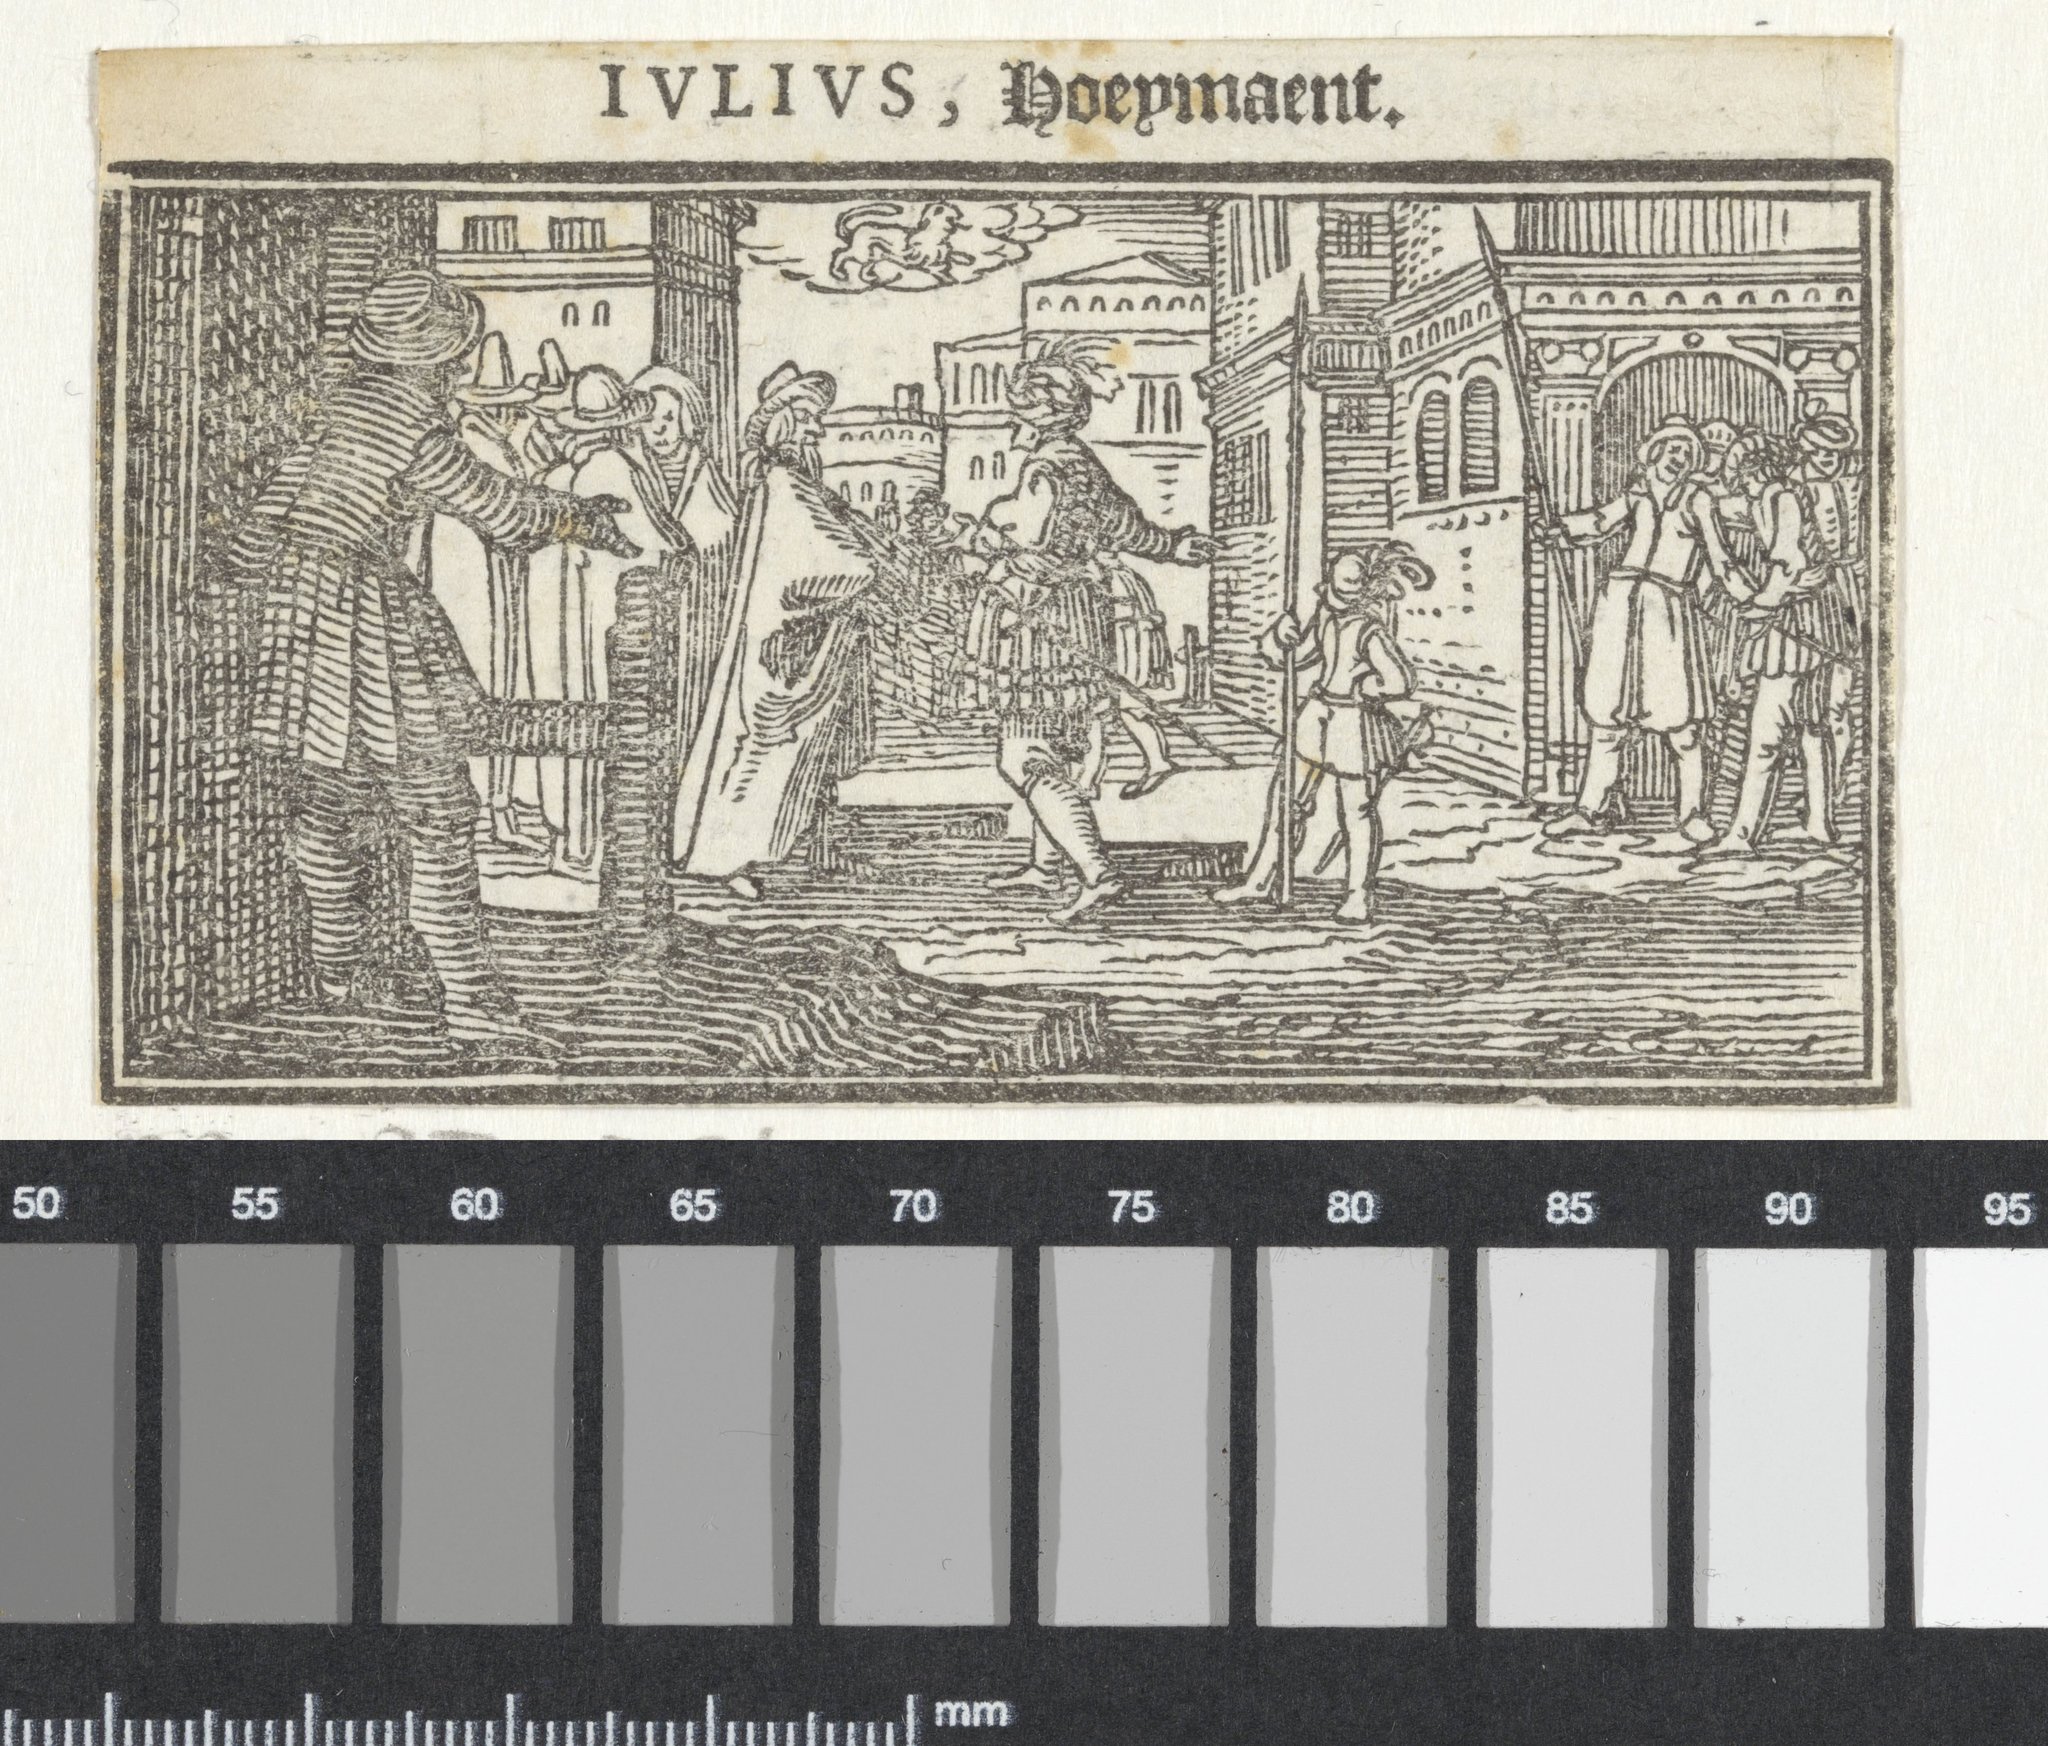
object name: book illustration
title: Maanden van het jaar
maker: Anonymous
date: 1600-1699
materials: paper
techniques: letterpress printing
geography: netherlands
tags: 23n31(+132)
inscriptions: collector's mark: Lugt 2228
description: Een rijk geklede man maakt een gebaar naar een groep mannen. Naast hem staat een jongen met een lans.